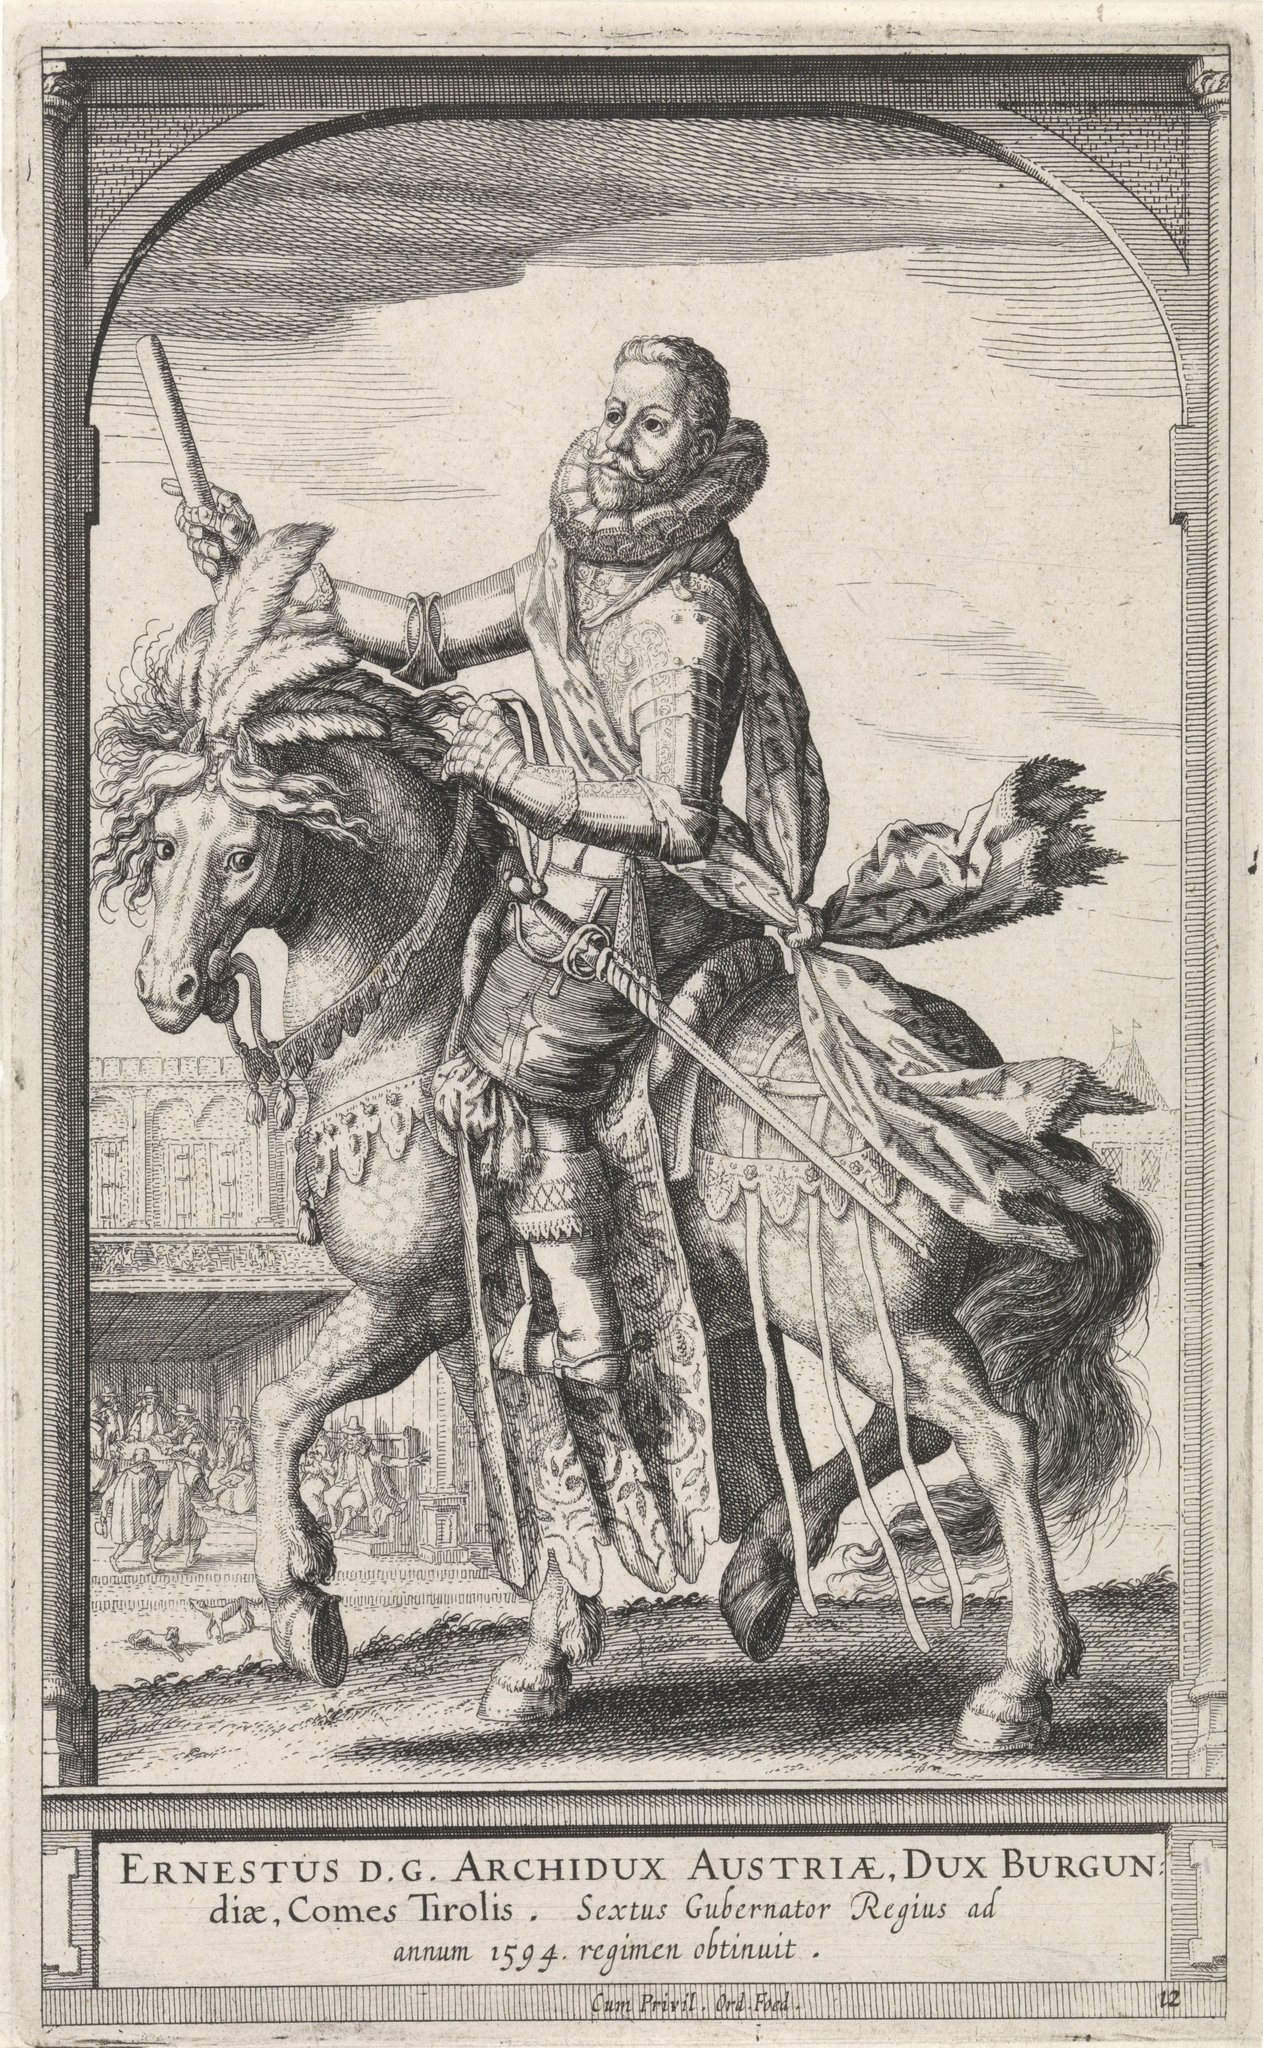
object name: print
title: Ernestus D.G. Archidux Austriae Dux Burgun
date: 1595-1632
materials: paper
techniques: etching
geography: amsterdam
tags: vienna, brussels, riding a horse, ass, or mule; rider, horseman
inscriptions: collector's mark: Lugt 2228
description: Ernst, aartshertog van Oostenrijk en landvoogd van de Nederlanden, te paard. Naar rechts. Hij heeft een staf in de hand. Op de achtergrond onderhandelingen met de Staten-Generaal. De prent heeft een Latijns onderschrift en maakt deel uit van een serie ruiterportretten van Nederlandse landvoogden.